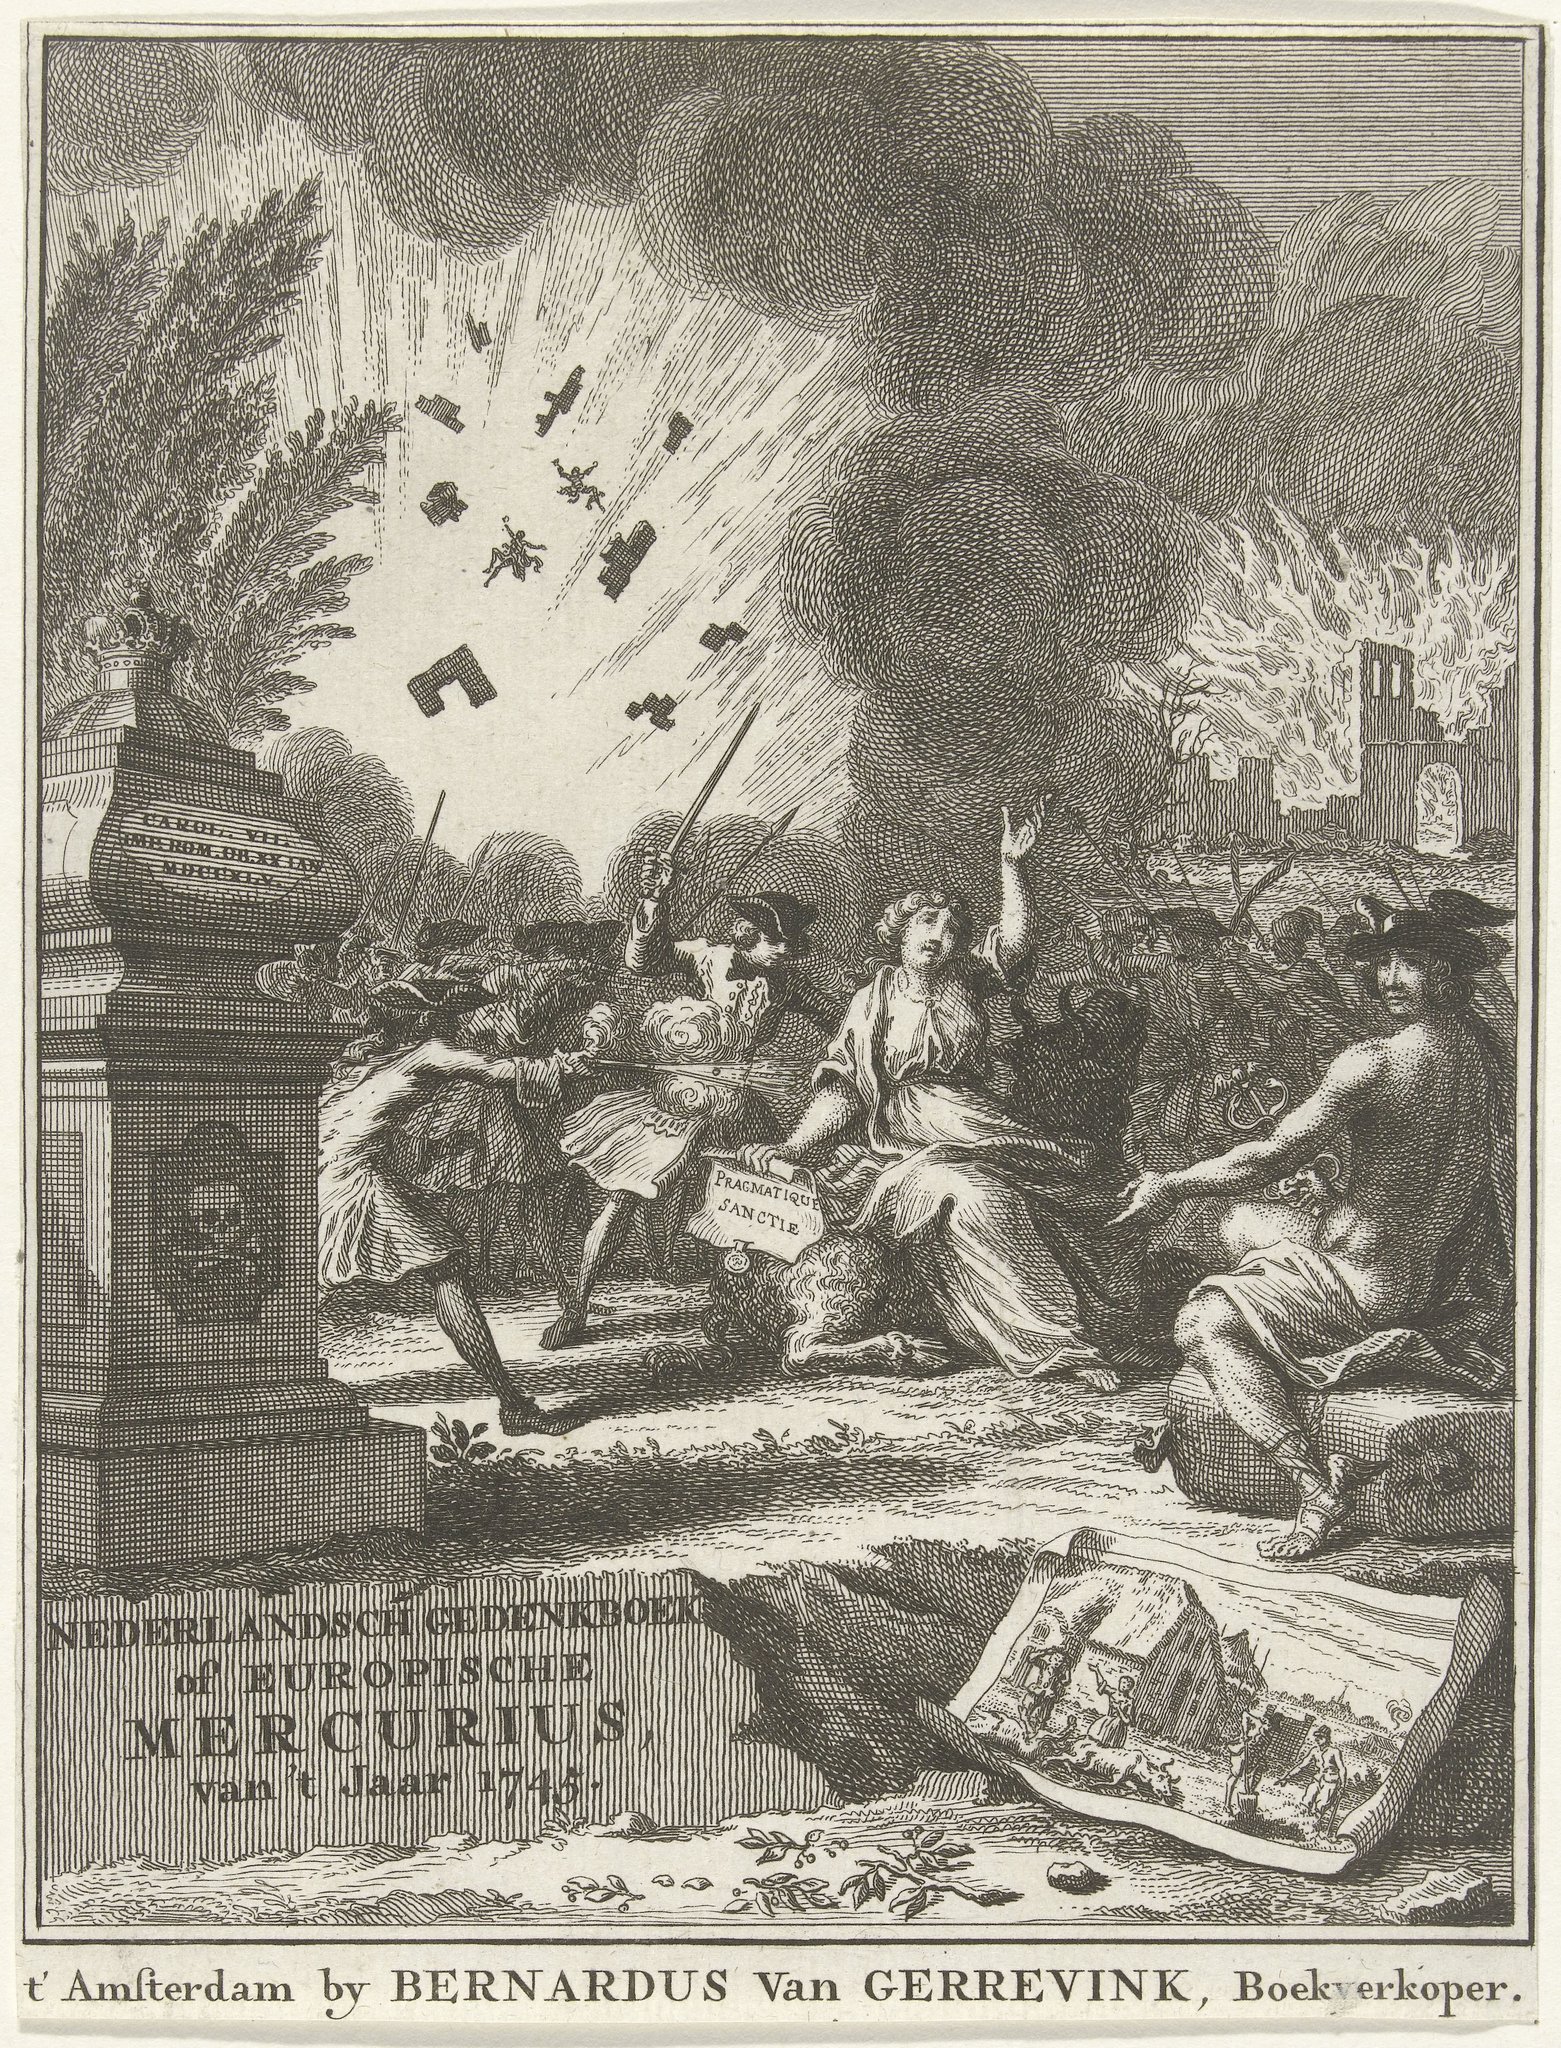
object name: titelblad, titelpagina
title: Titelpagina voor de Europische Mercurius van 1745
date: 1745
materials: paper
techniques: engraving, etching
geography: amsterdam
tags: brussels, karel vii albrecht (duits keizer), grave, tomb, battle (+ land forces)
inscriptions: collector's mark: Lugt 2228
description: Titelpagina voor het Nederlandsch Gedenkboek of Europische Mercurius, over het jaar 1745. Europa met in de hand de Pragmatieke Sanctie terwijl om haar heen de oorlog woedt. Links het grafmonument voor de in januari 1745 overleden keizer Karel VII Albert. Op de voorgrond ligt een blad met een voorstelling van de veesterfte.